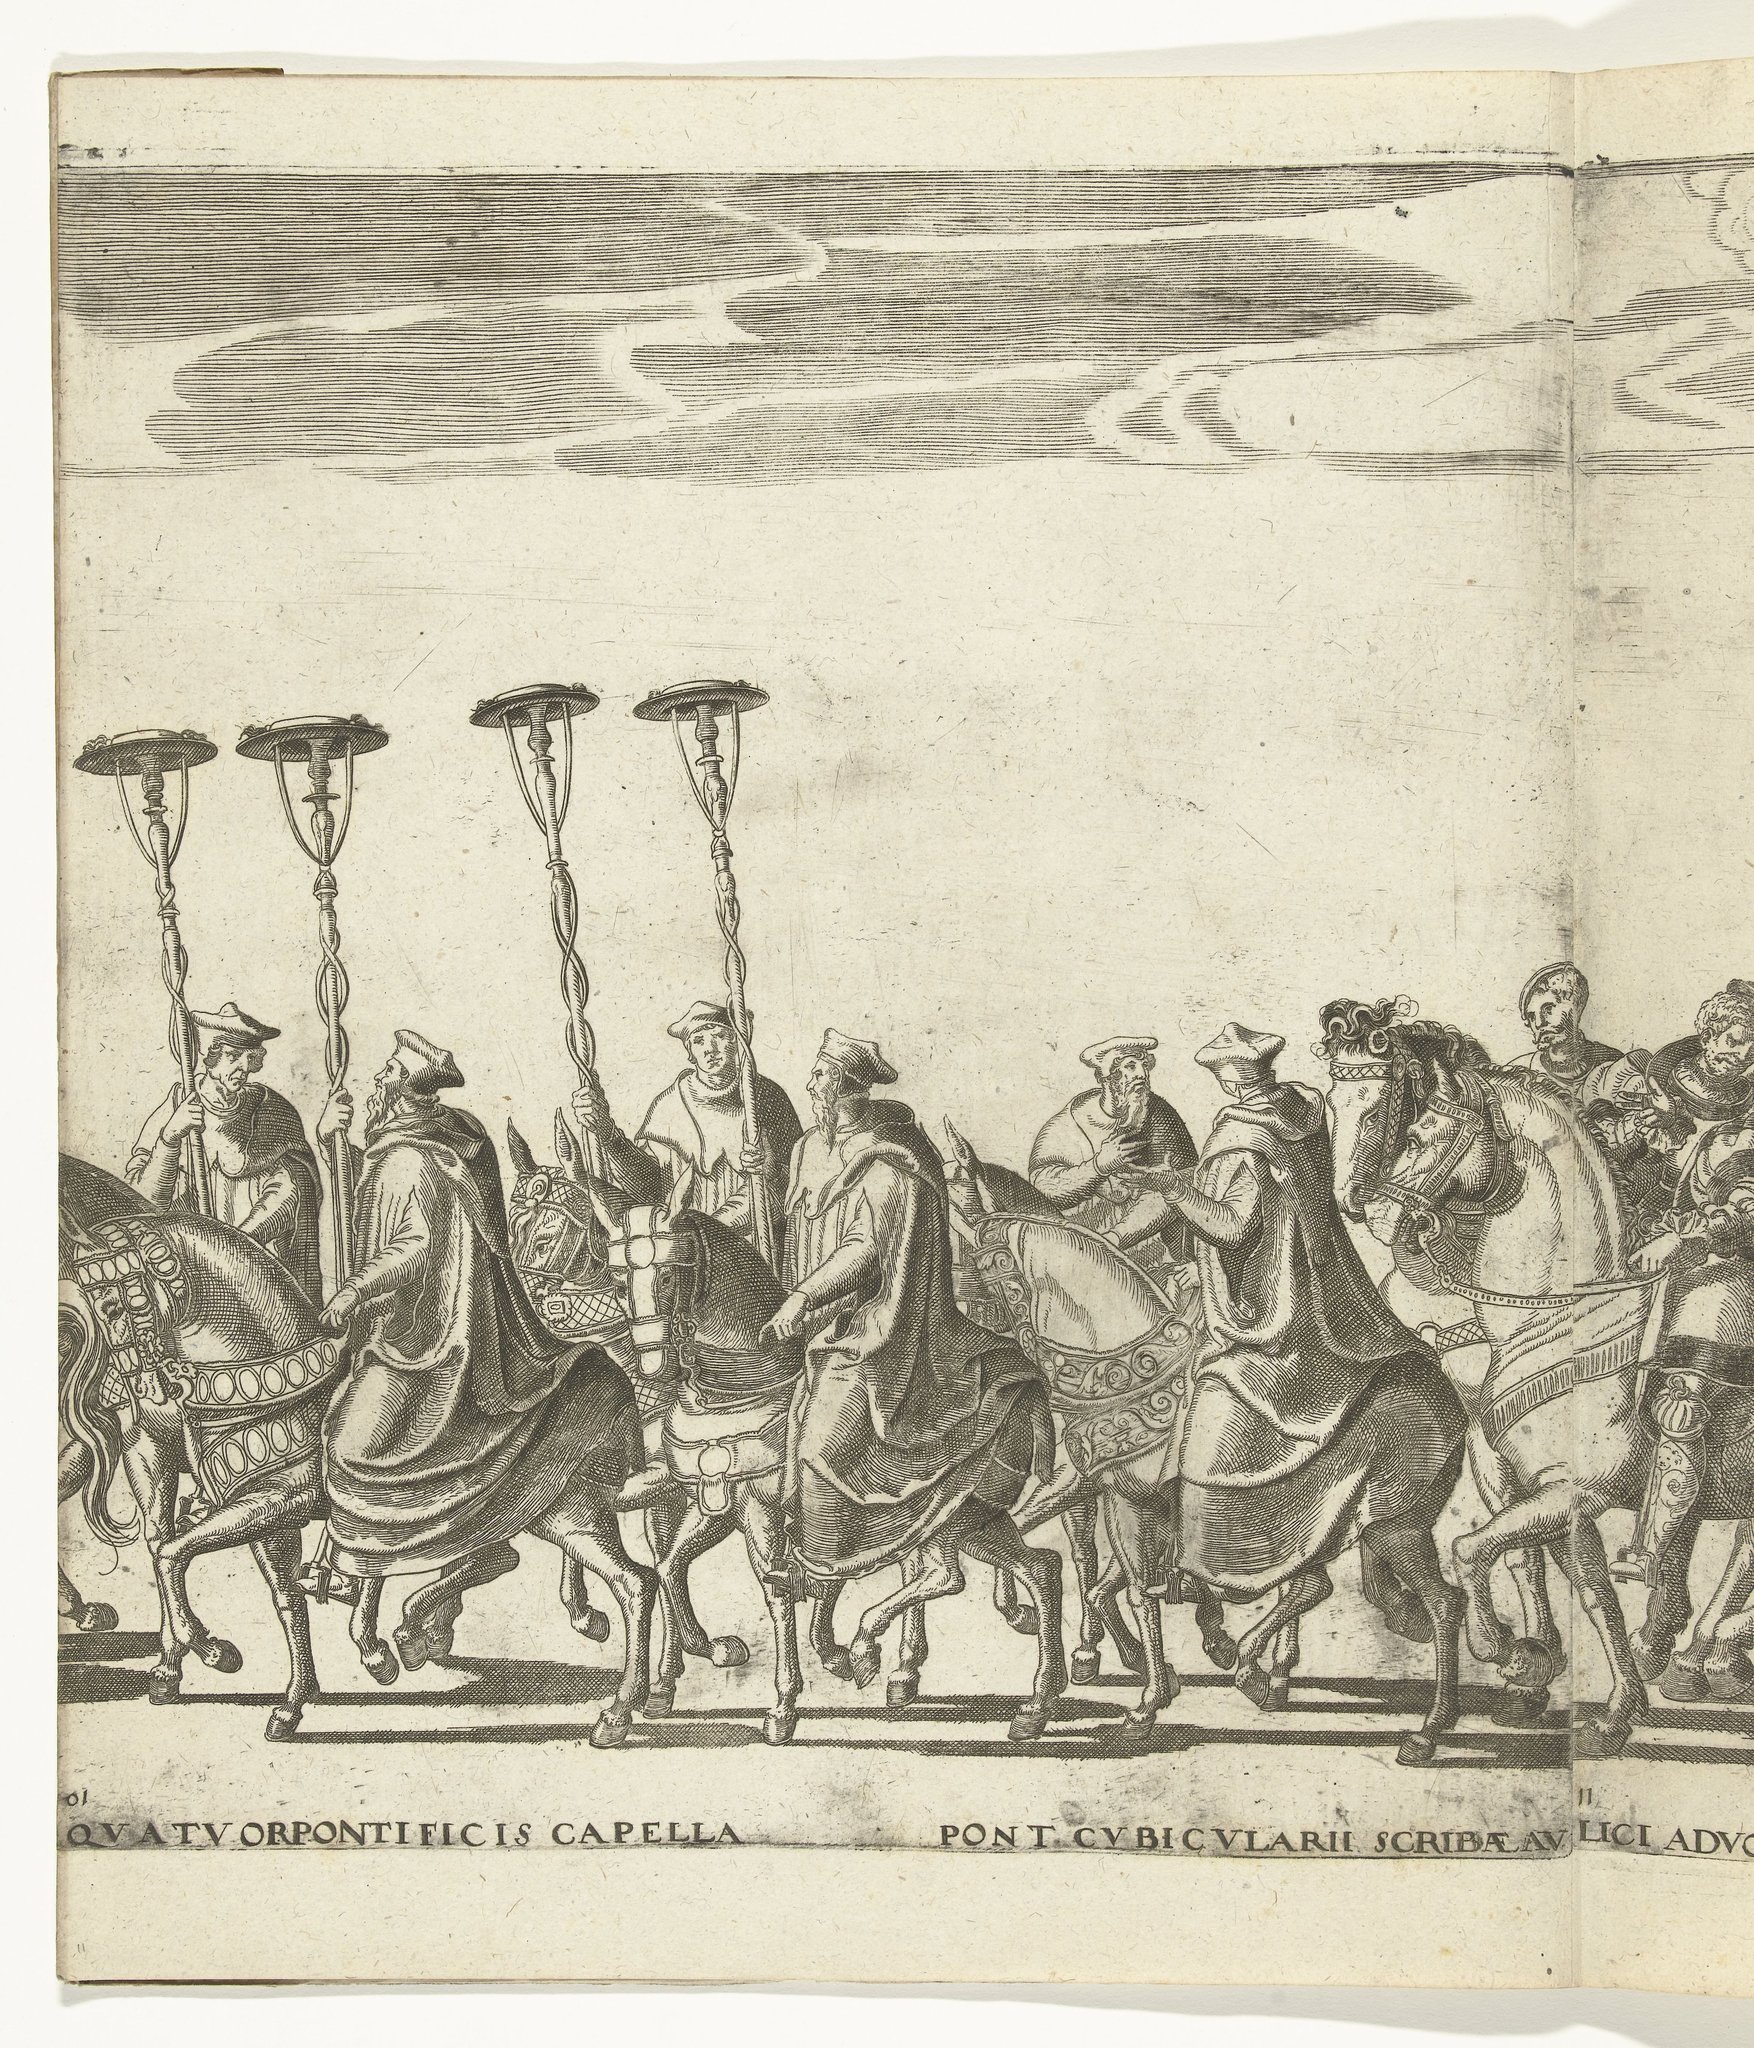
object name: print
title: Vier kardinaalshoeden op stokken, plaat 10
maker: nicolaas hogenberg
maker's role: draughtsman, painter, print maker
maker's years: 1500-1539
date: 1530-1536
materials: paper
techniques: engraving, etching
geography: mechelen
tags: charles v (holy roman emperor and king of spain), festivities (+ parade, pageant, cavalcade ~ festive activities)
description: In plaats van de geneologische afstamming van Karel V in het huis van Oostenrijk is in deze uitgave bovenin de platen een nieuw lucht gegraveerd. De platen zijn genummerd 1-38. Deze uitgave is later dan die van Hondius. De platen zijn aanelkaar geplakt en vormen zo één lang (opgevouwen) fries. Het opgevouwen fries ligt los in een map.